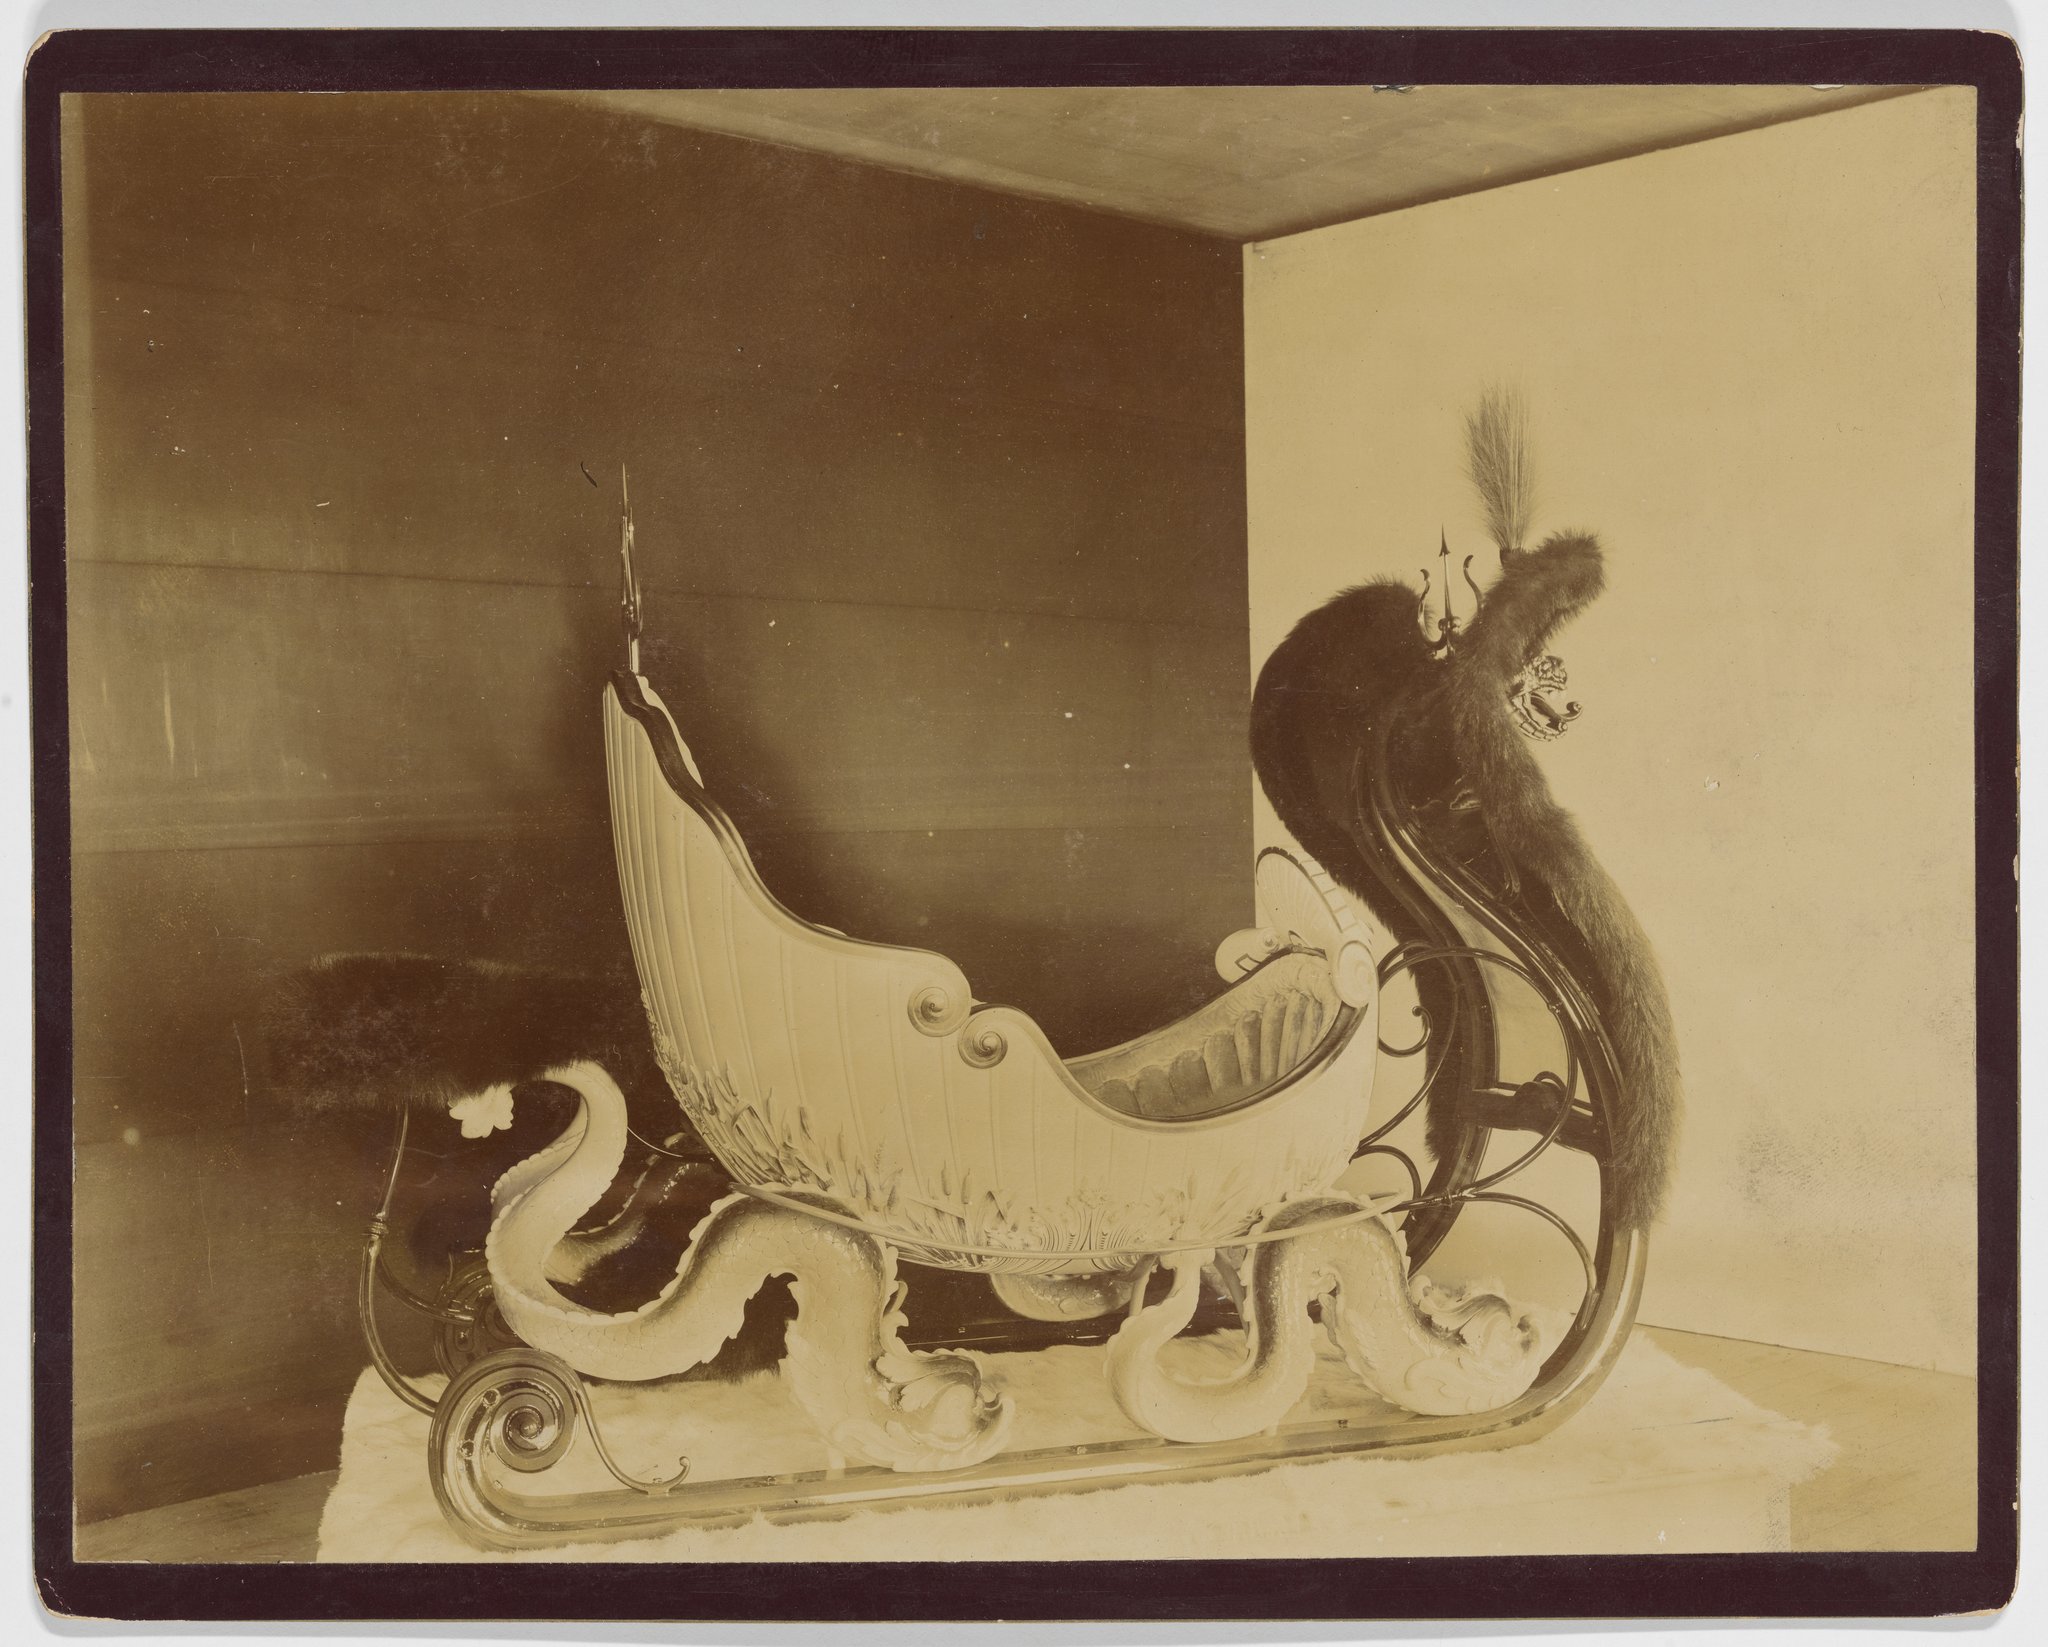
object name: drawing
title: Exhibition Sleigh #4200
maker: brewster & co.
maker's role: manufacturer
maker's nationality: american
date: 1893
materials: board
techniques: photography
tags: sleighs